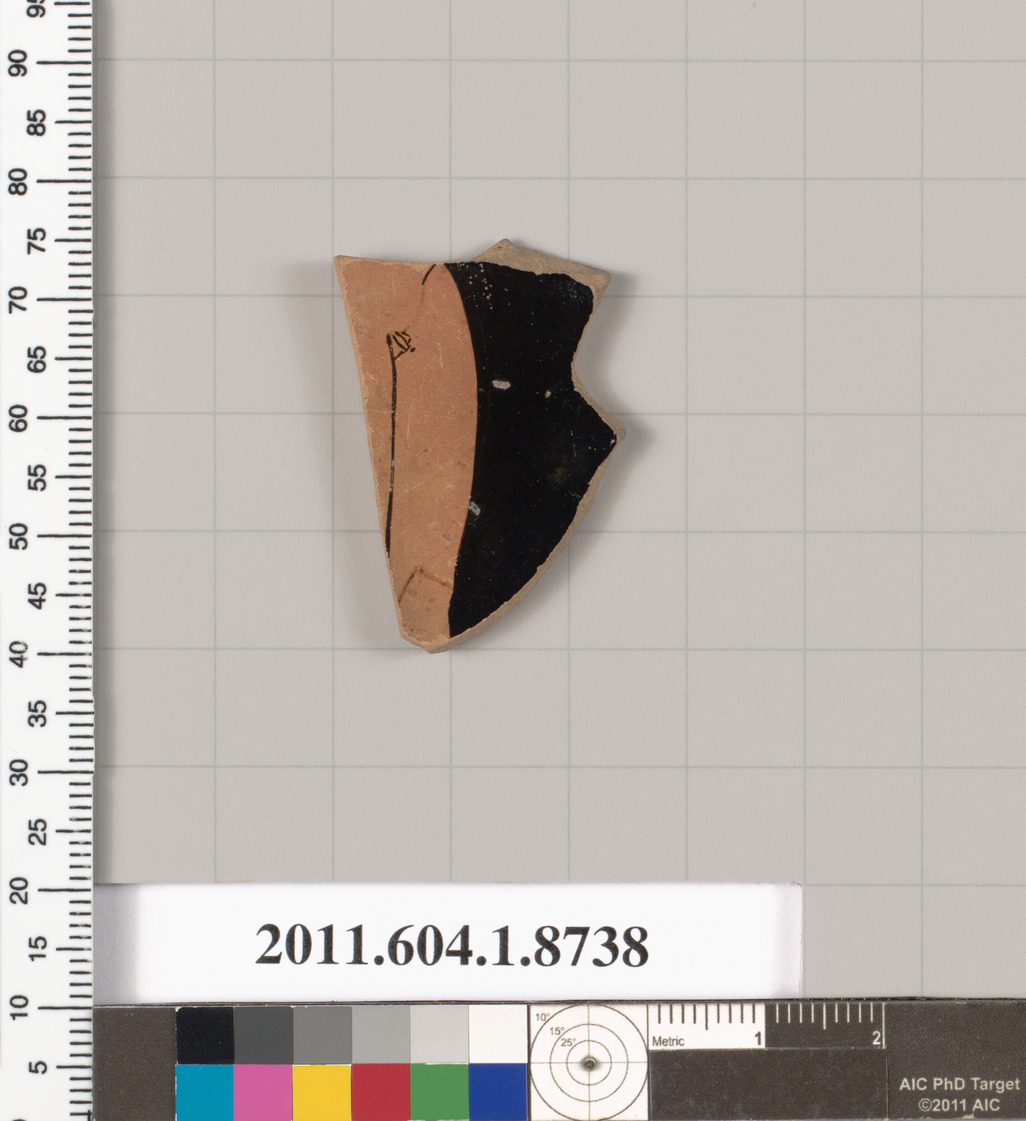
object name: kylix fragment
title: Terracotta fragment of a stemless cup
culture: greek, attic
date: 460-450 BCE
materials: terracotta